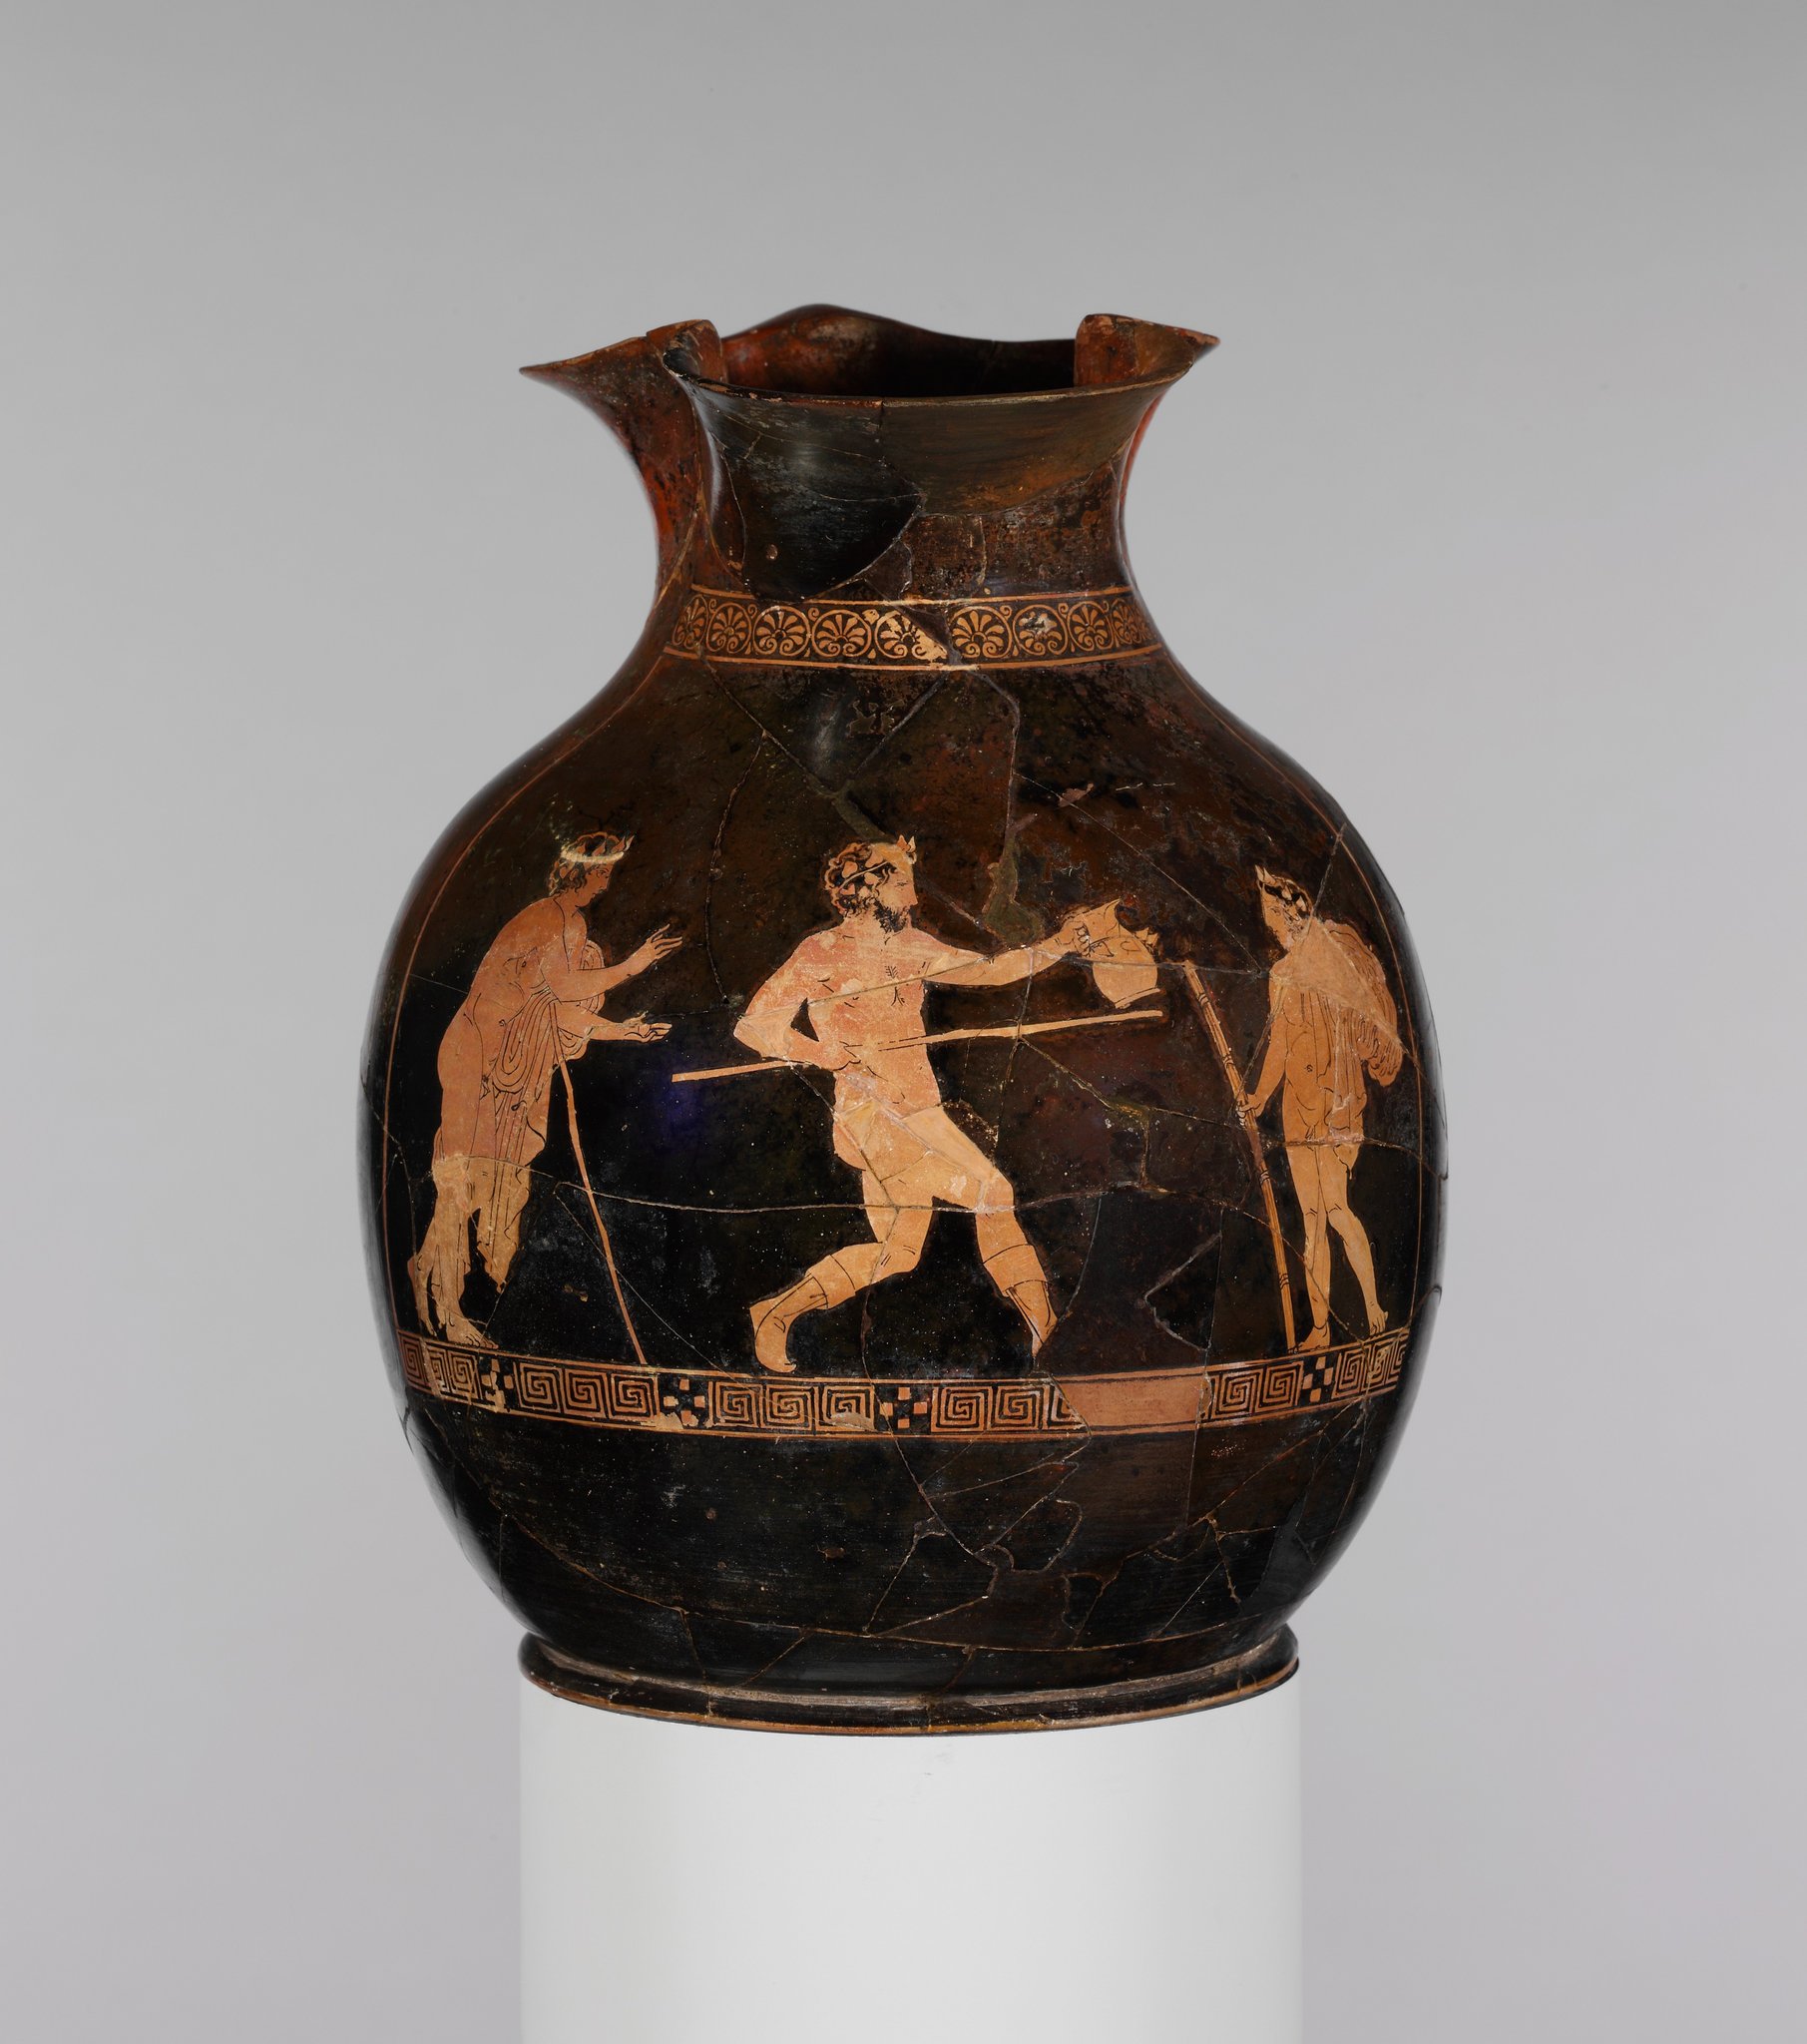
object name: oinochoe, chou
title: Terracotta oinochoe: chous (jug)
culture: greek, attic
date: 420 BCE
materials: terracotta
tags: men